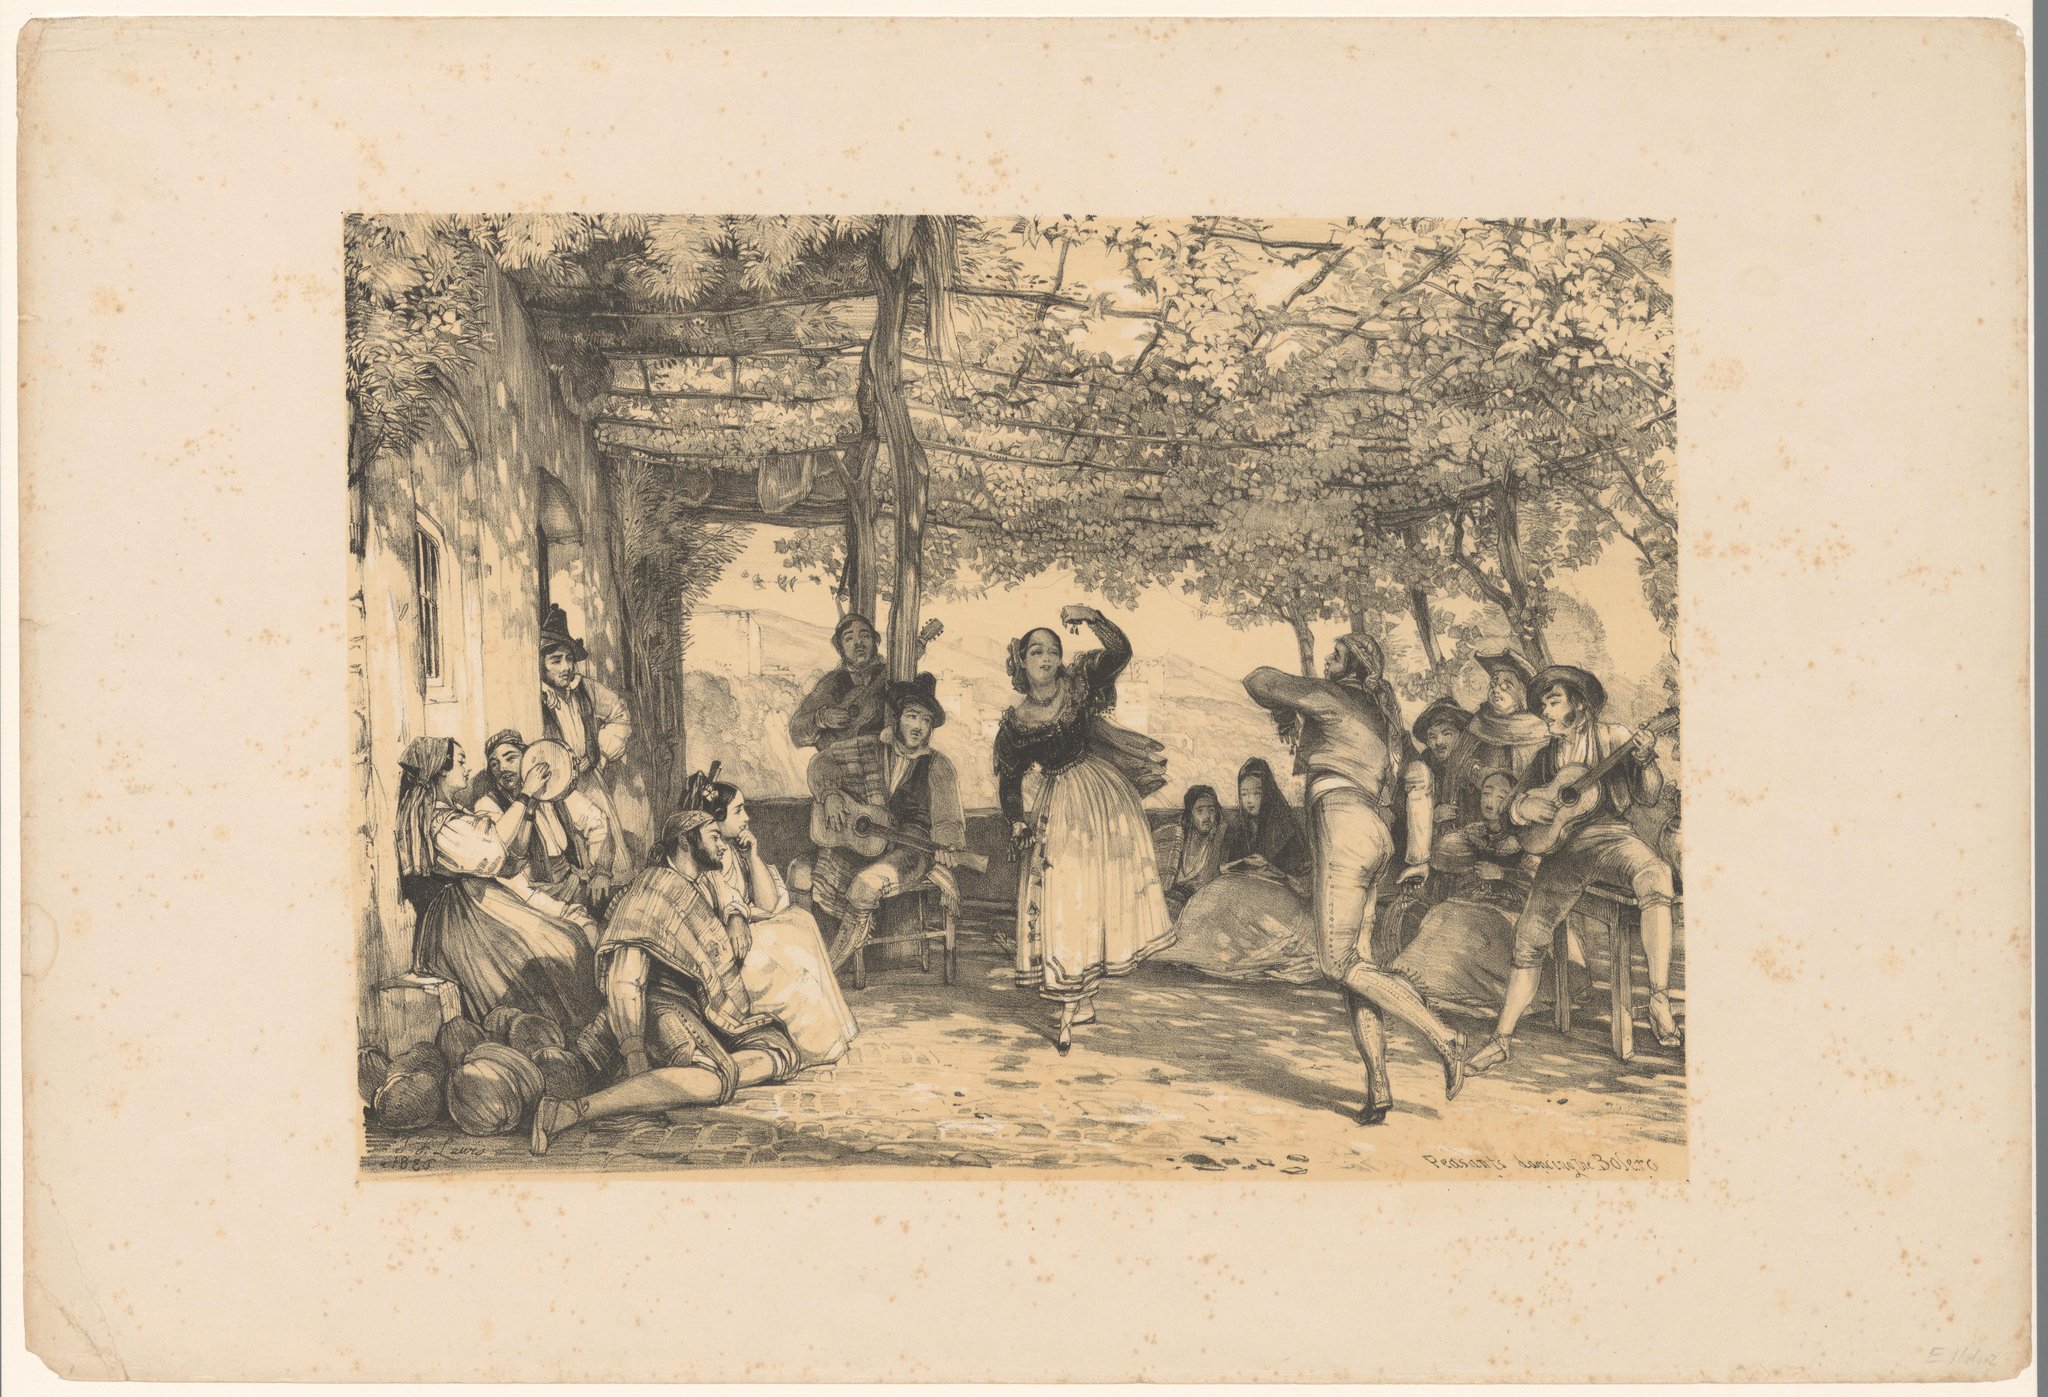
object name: print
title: Boeren dansen de bolero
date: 1836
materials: paper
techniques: tone lithography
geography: london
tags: musician - cc - out of doors, one pair dancing; man and woman dancing as a couple, more than one musician with instrument, spain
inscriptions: collector's mark: Lugt 2228